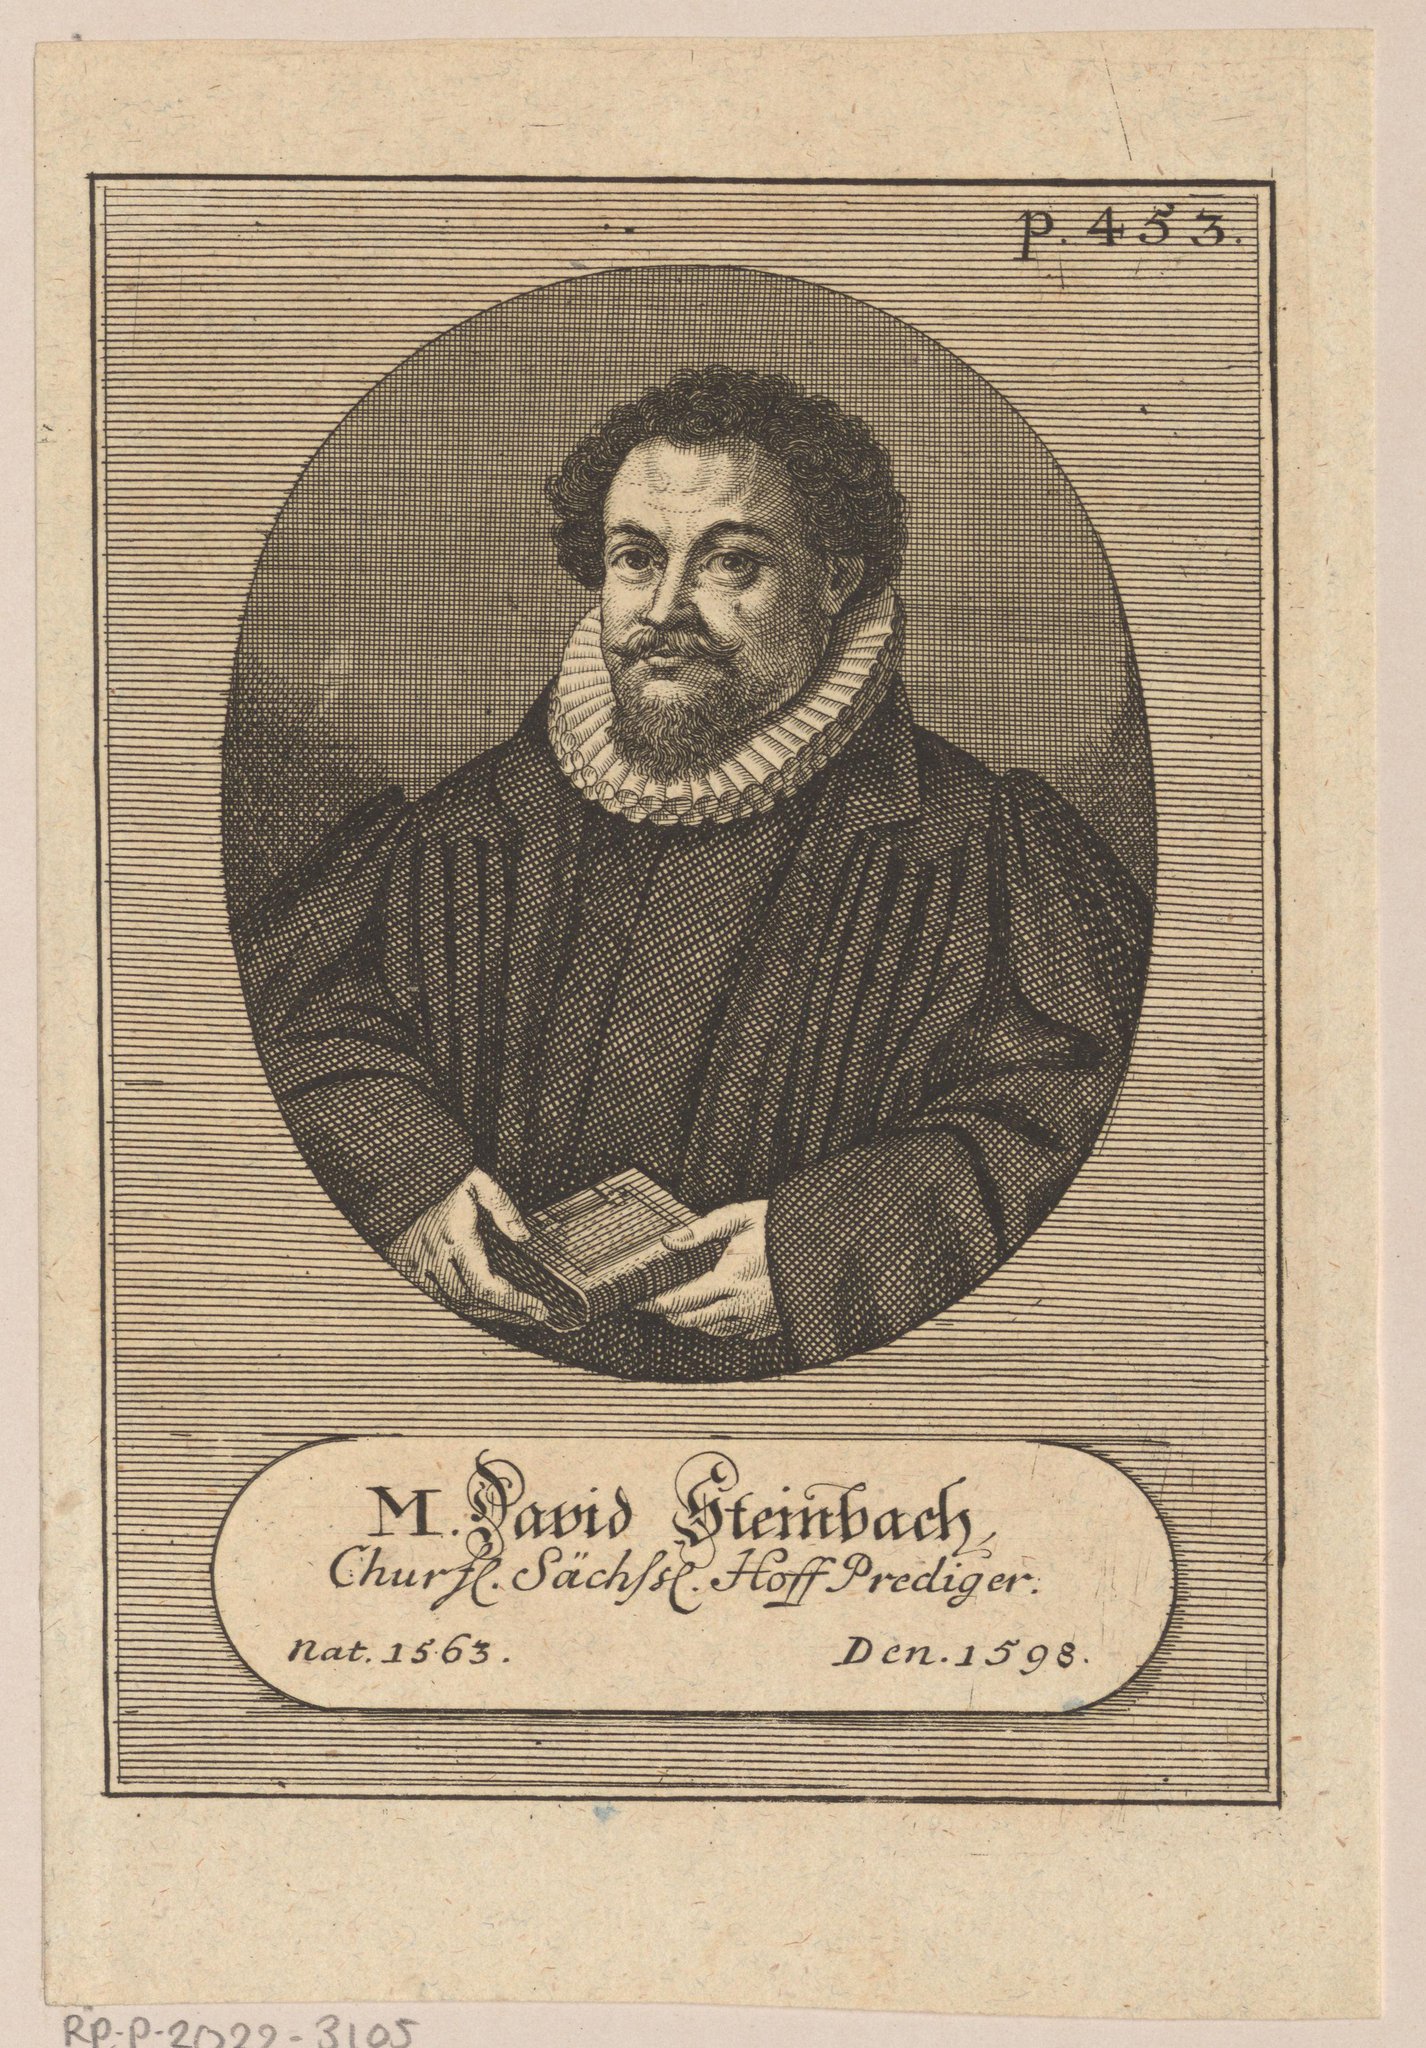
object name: print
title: Portret van David Steinbach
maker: Anonymous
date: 1730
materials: paper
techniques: engraving, etching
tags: historical persons, functionaries and dignitaries (with name) ~ episcopal protestant churches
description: Prent waarschijnlijk uit: Gleich, Johann Andreas. Annales ecclesiastici oder Gründliche Nachrichten der Reformations-Historie, Chur-Sächss. Albertinischer Linie. Dresden/Leipzig: Raphael Christian Sauereßigs, 1730.